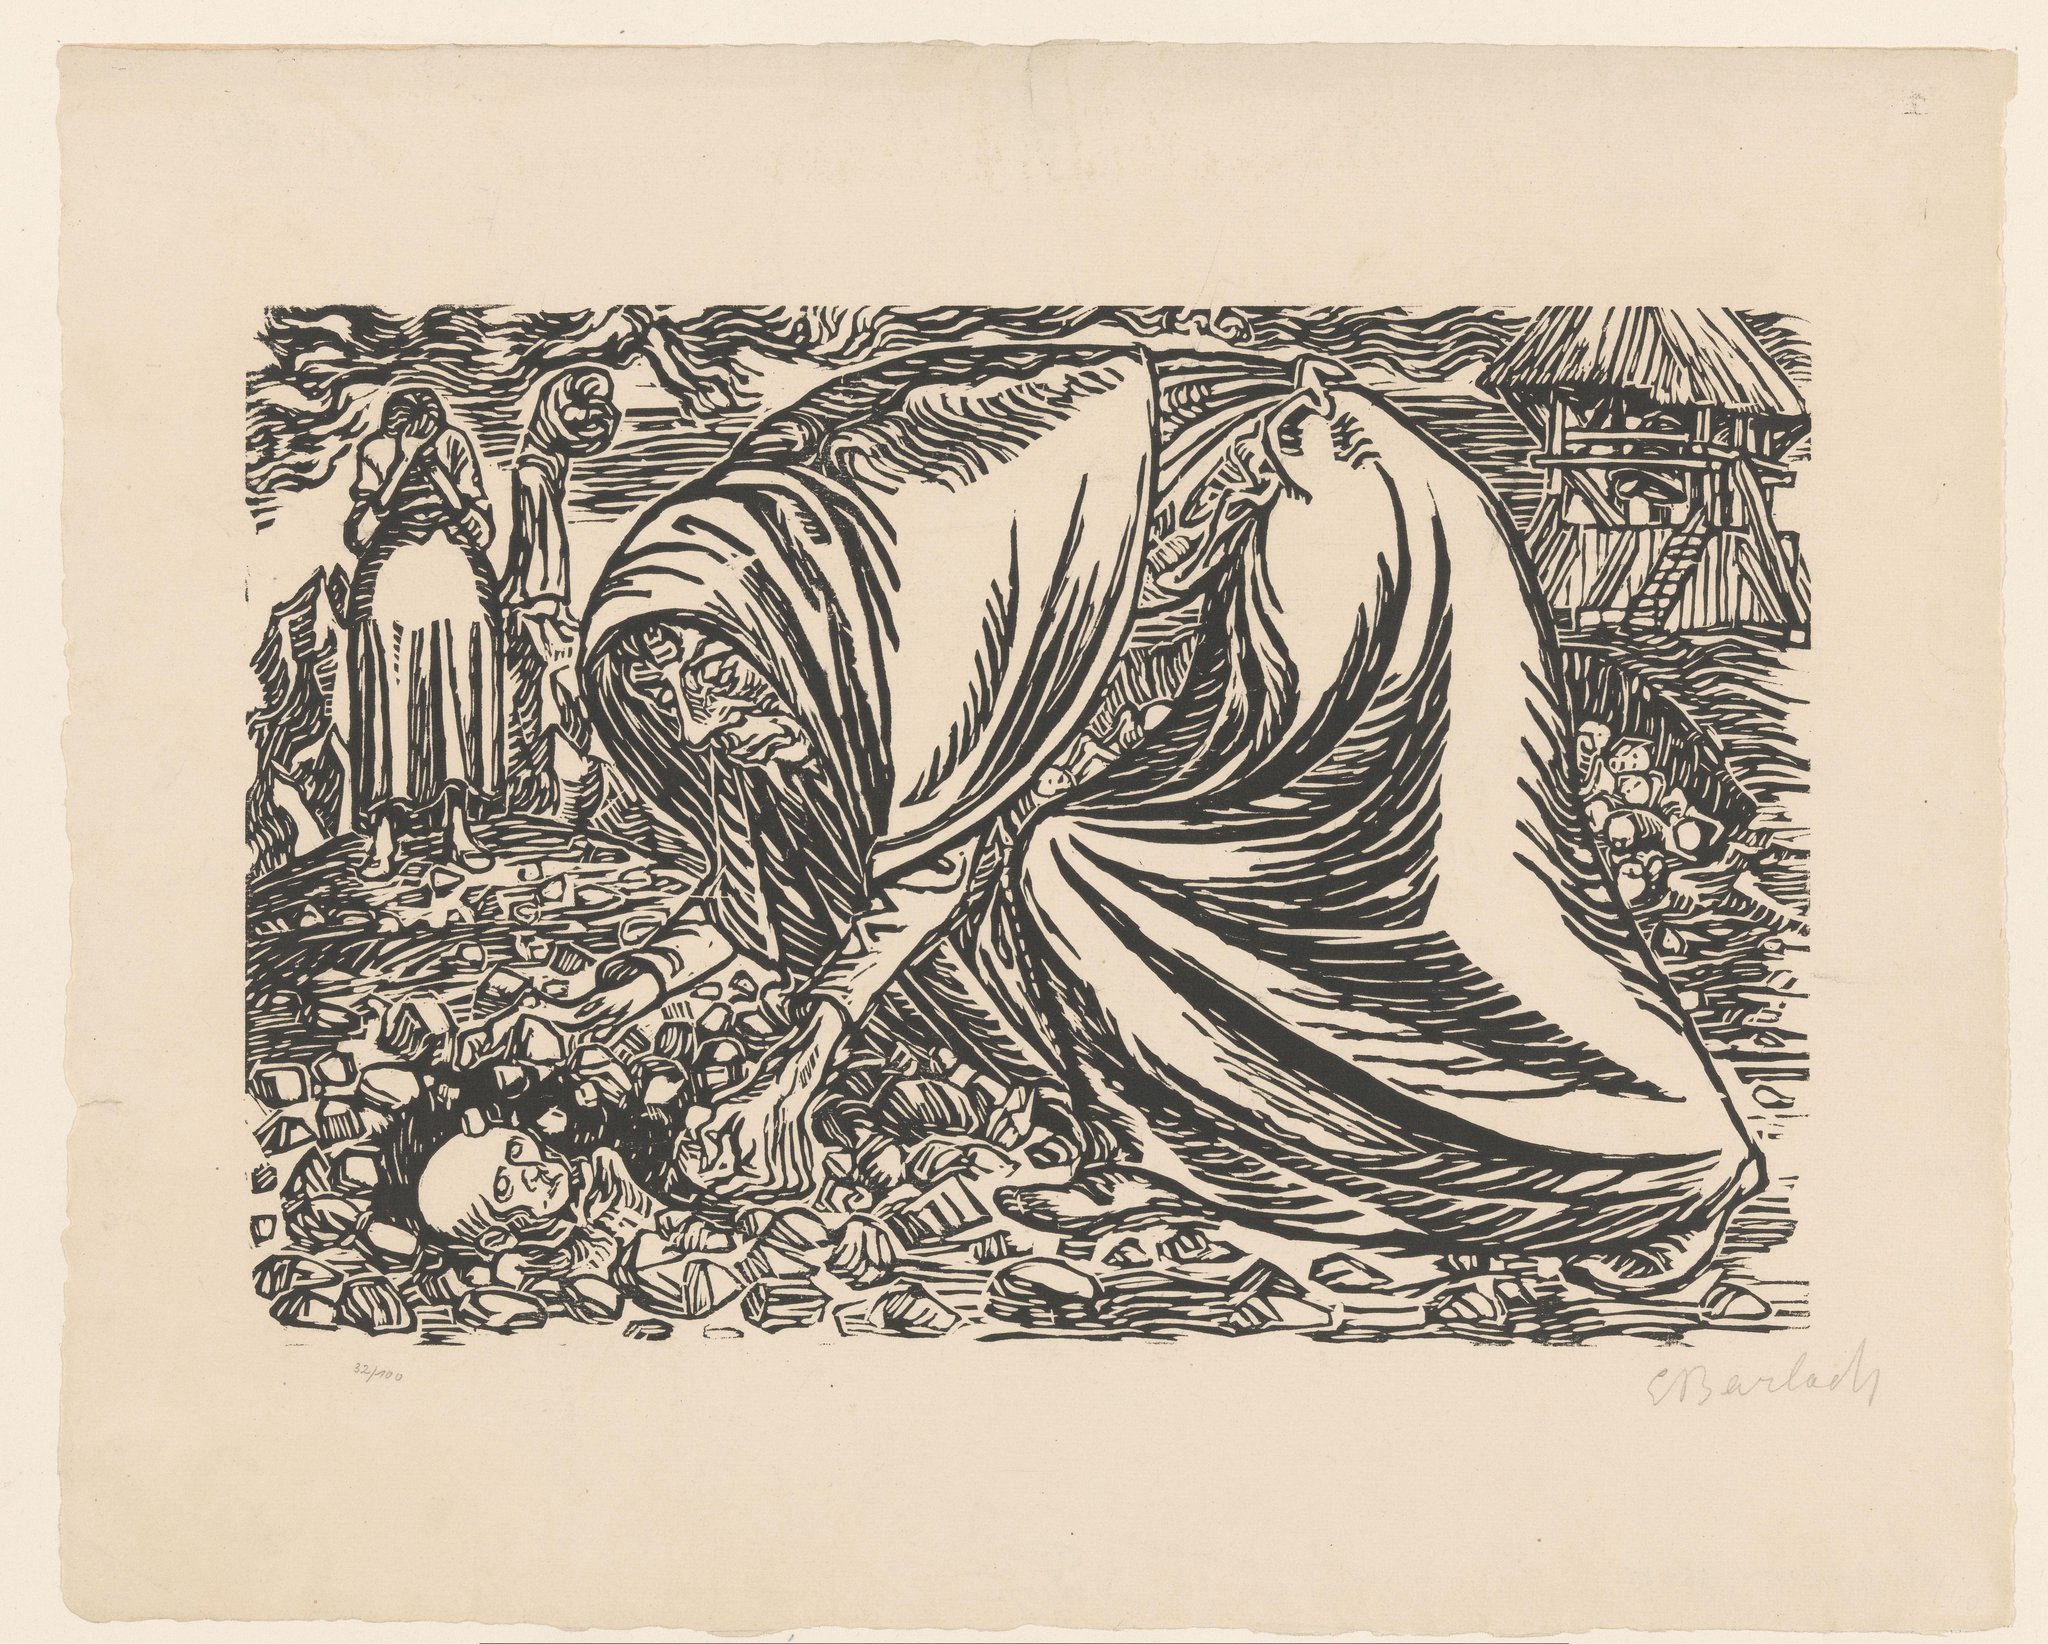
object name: print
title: Dood kind wordt begraven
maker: ernst barlach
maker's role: print maker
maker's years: 1870-1938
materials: paper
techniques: woodcut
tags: burial, death of a child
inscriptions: number: ‘(32/100)’, collector's mark: Lugt 2228